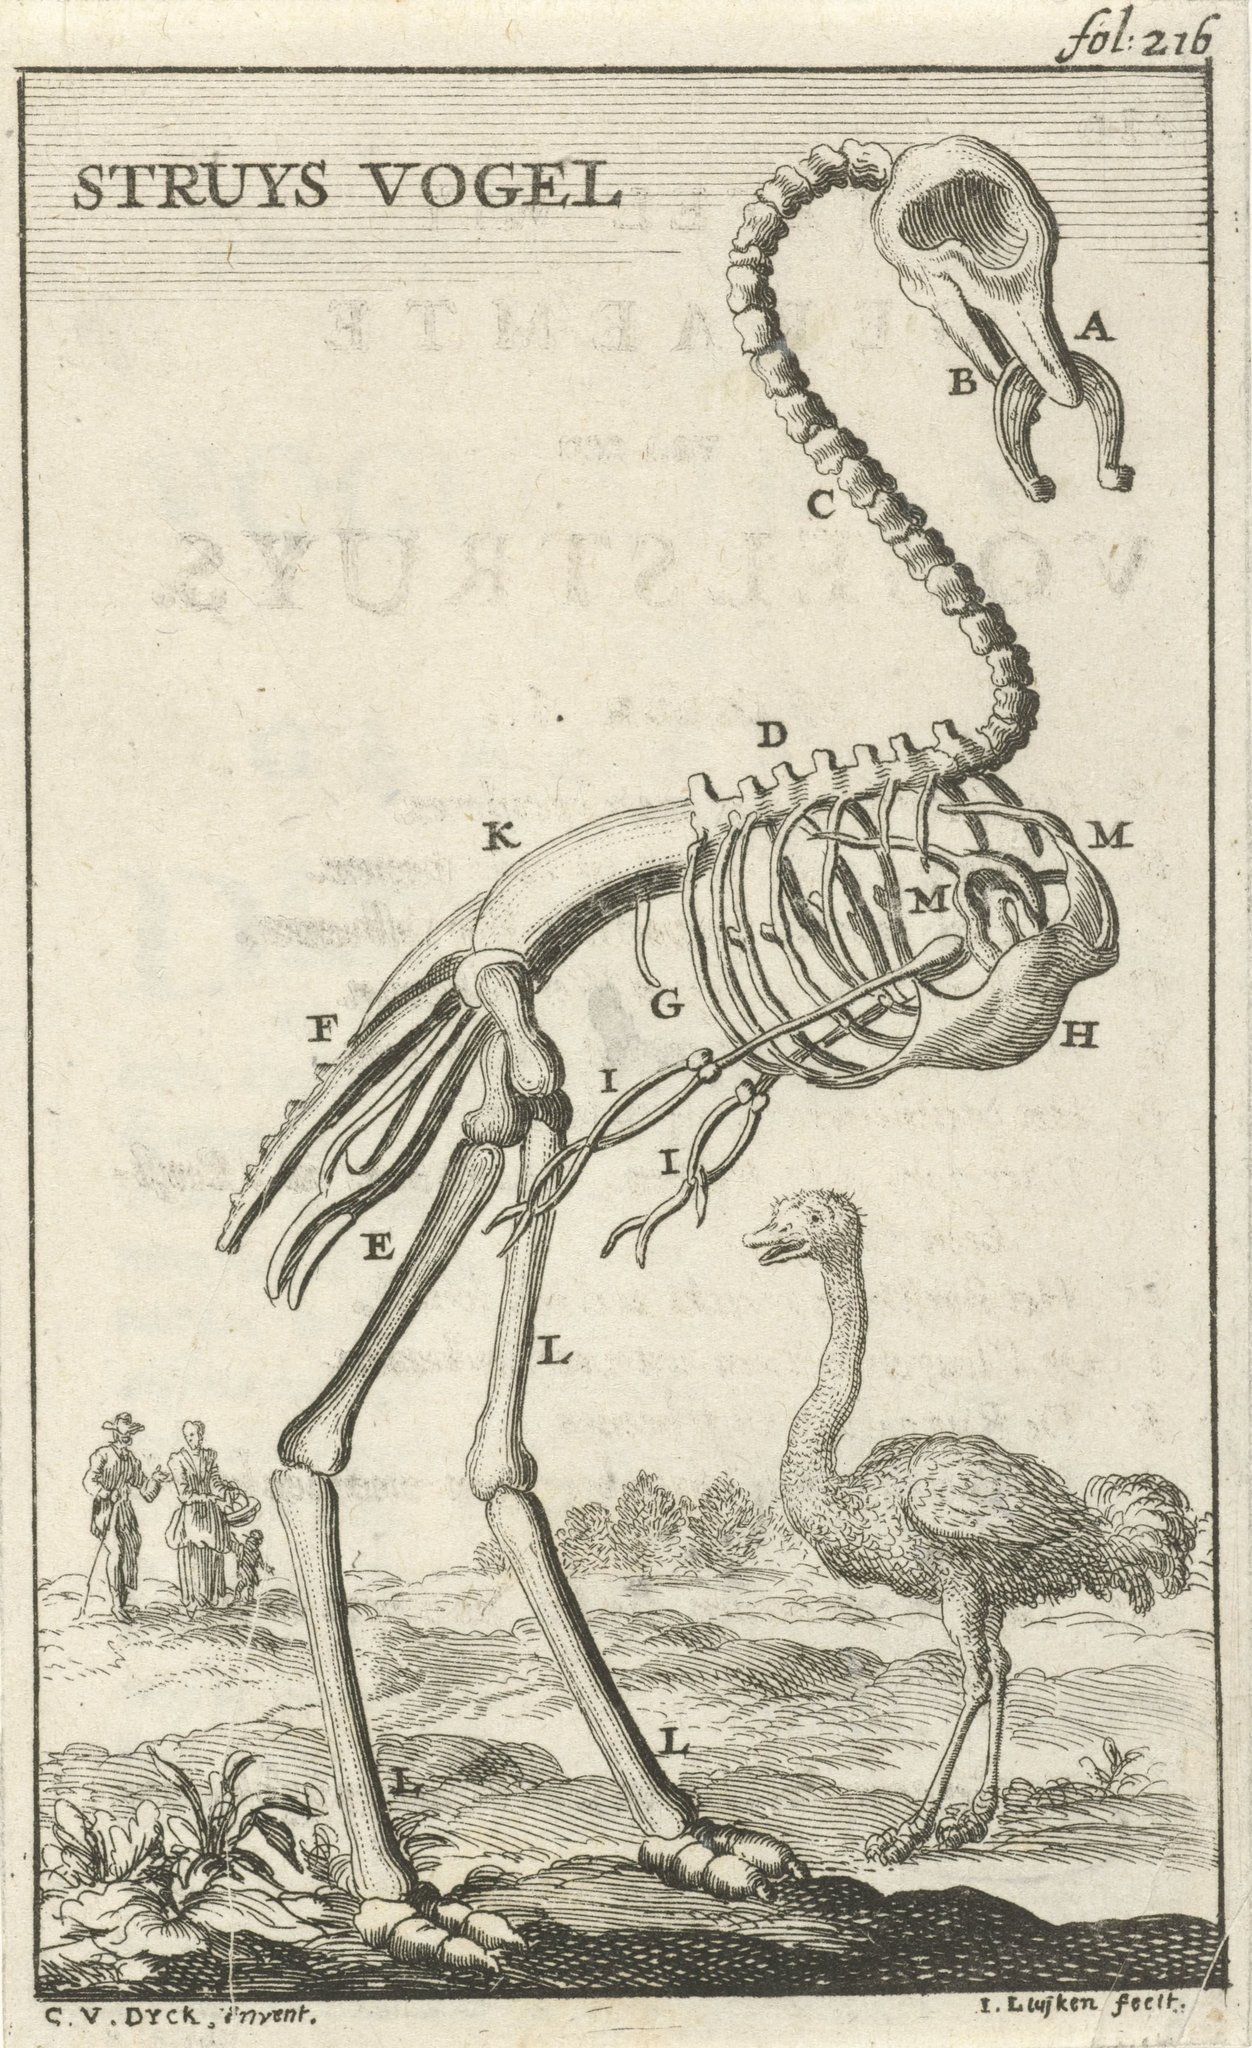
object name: book illustration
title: Geraamte van een struisvogel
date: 1680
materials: paper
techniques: etching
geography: amsterdam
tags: animals (+ skeleton of an animal), walker and runner birds: ostrich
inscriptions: collector's mark: Lugt 2228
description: Illustratie opgenomen in: Dyk, Cornelis van. Osteologia, of nauwkeurige geraamt beschryving van verscheyde dieren, nevens hare historien. Amsterdam: Jan Claesz ten Hoorn, 1680.